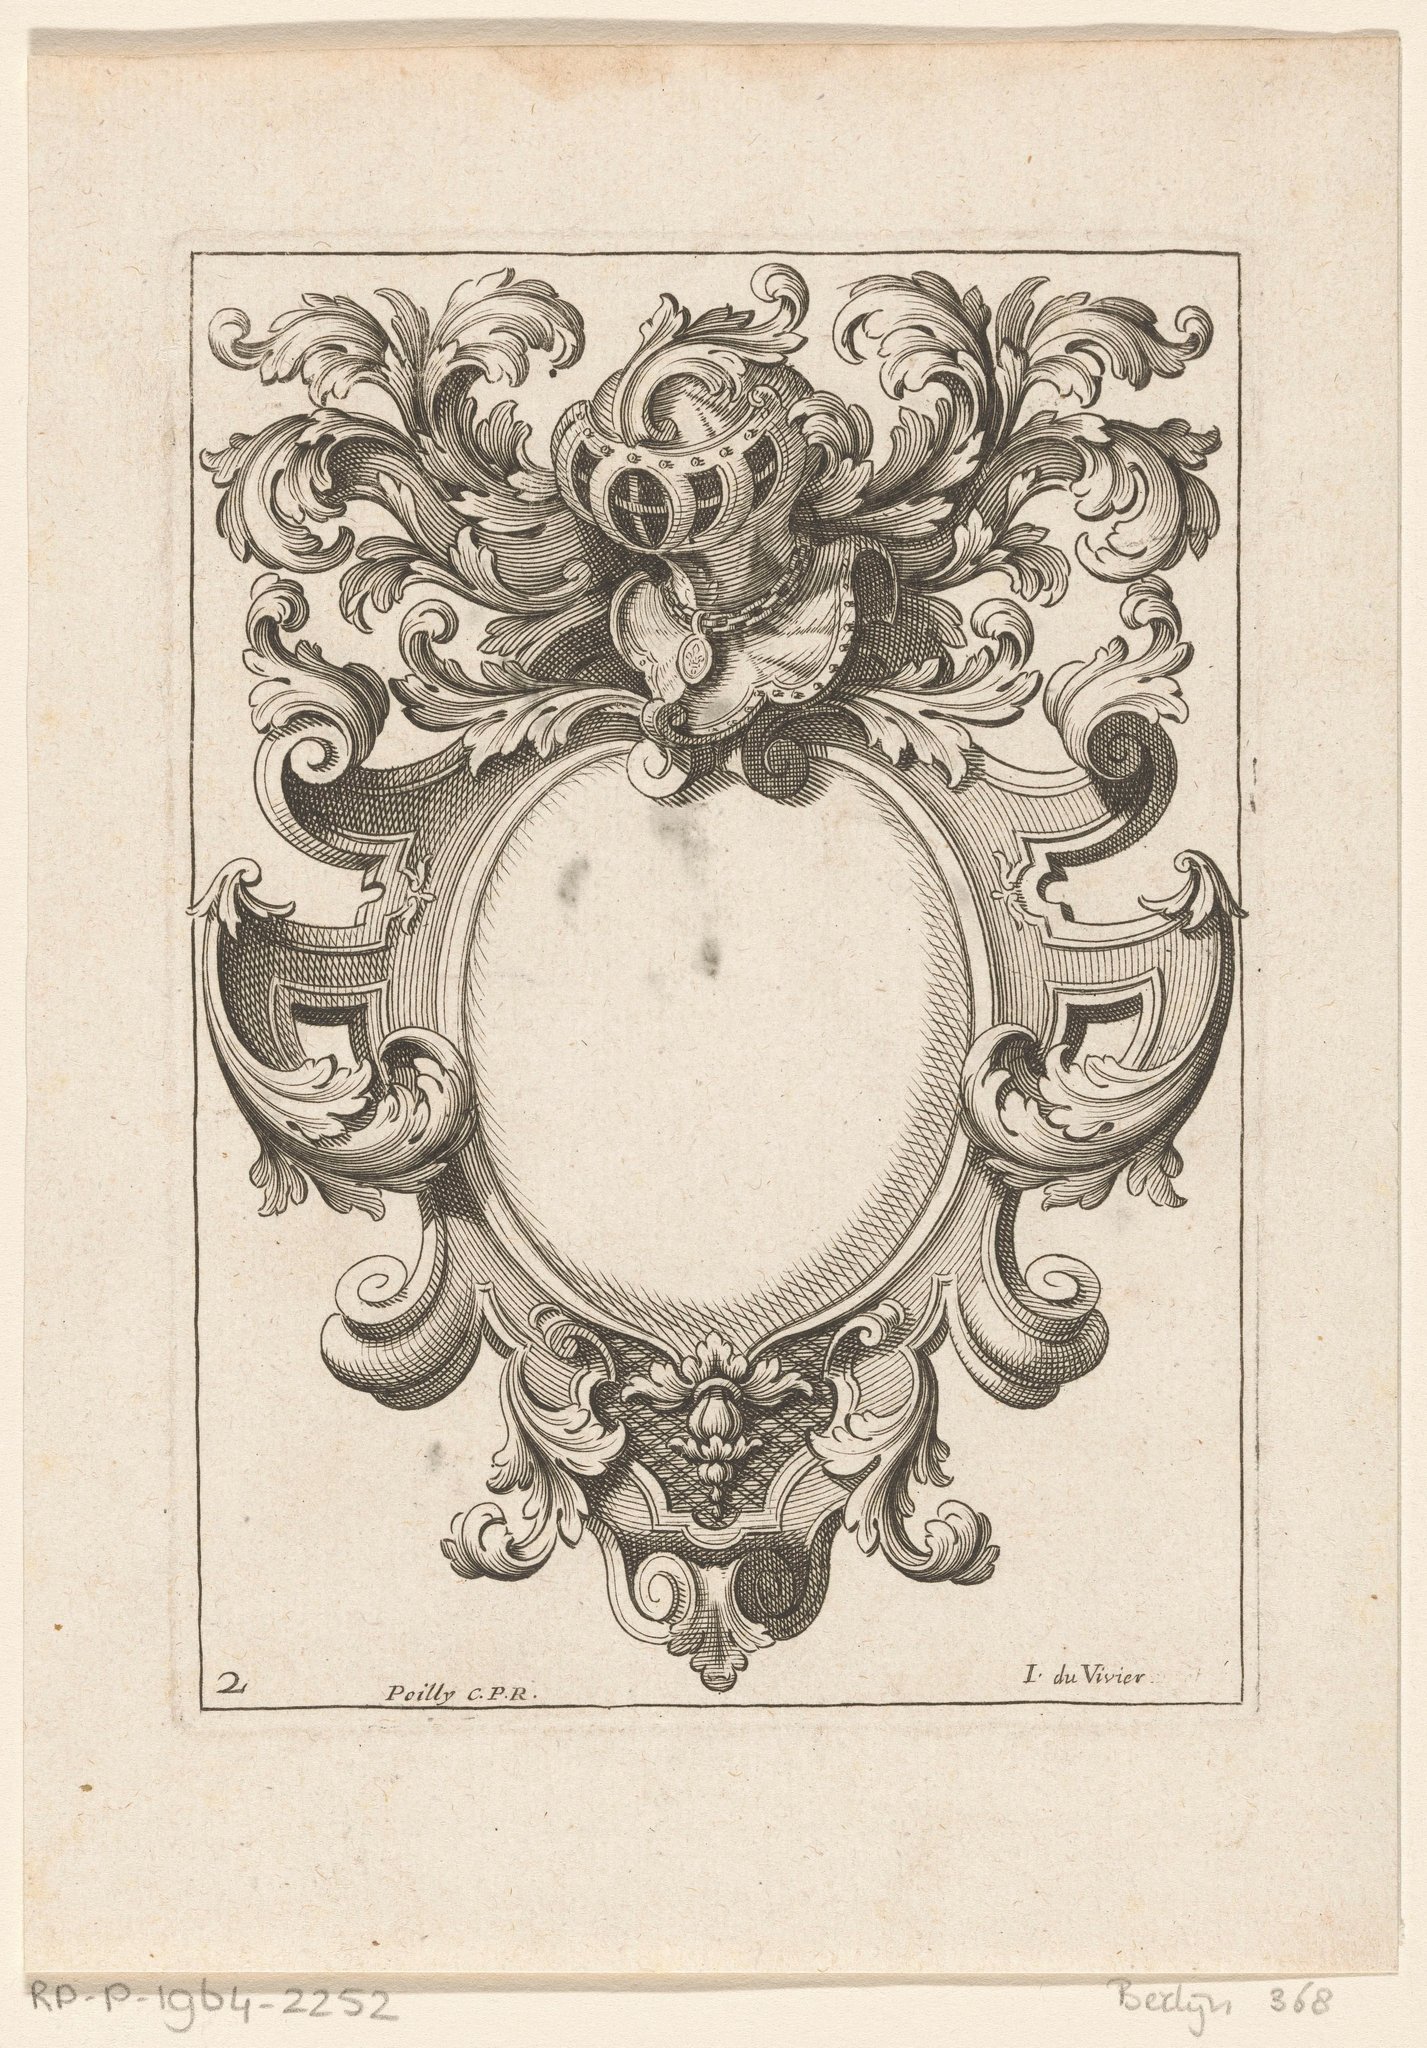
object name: ornament print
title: Cartouche met helm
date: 1712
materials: paper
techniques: engraving, etching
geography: paris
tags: helmet, ornament ~ cartouche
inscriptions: collector's mark: Lugt 2760, collector's mark: Lugt 2228